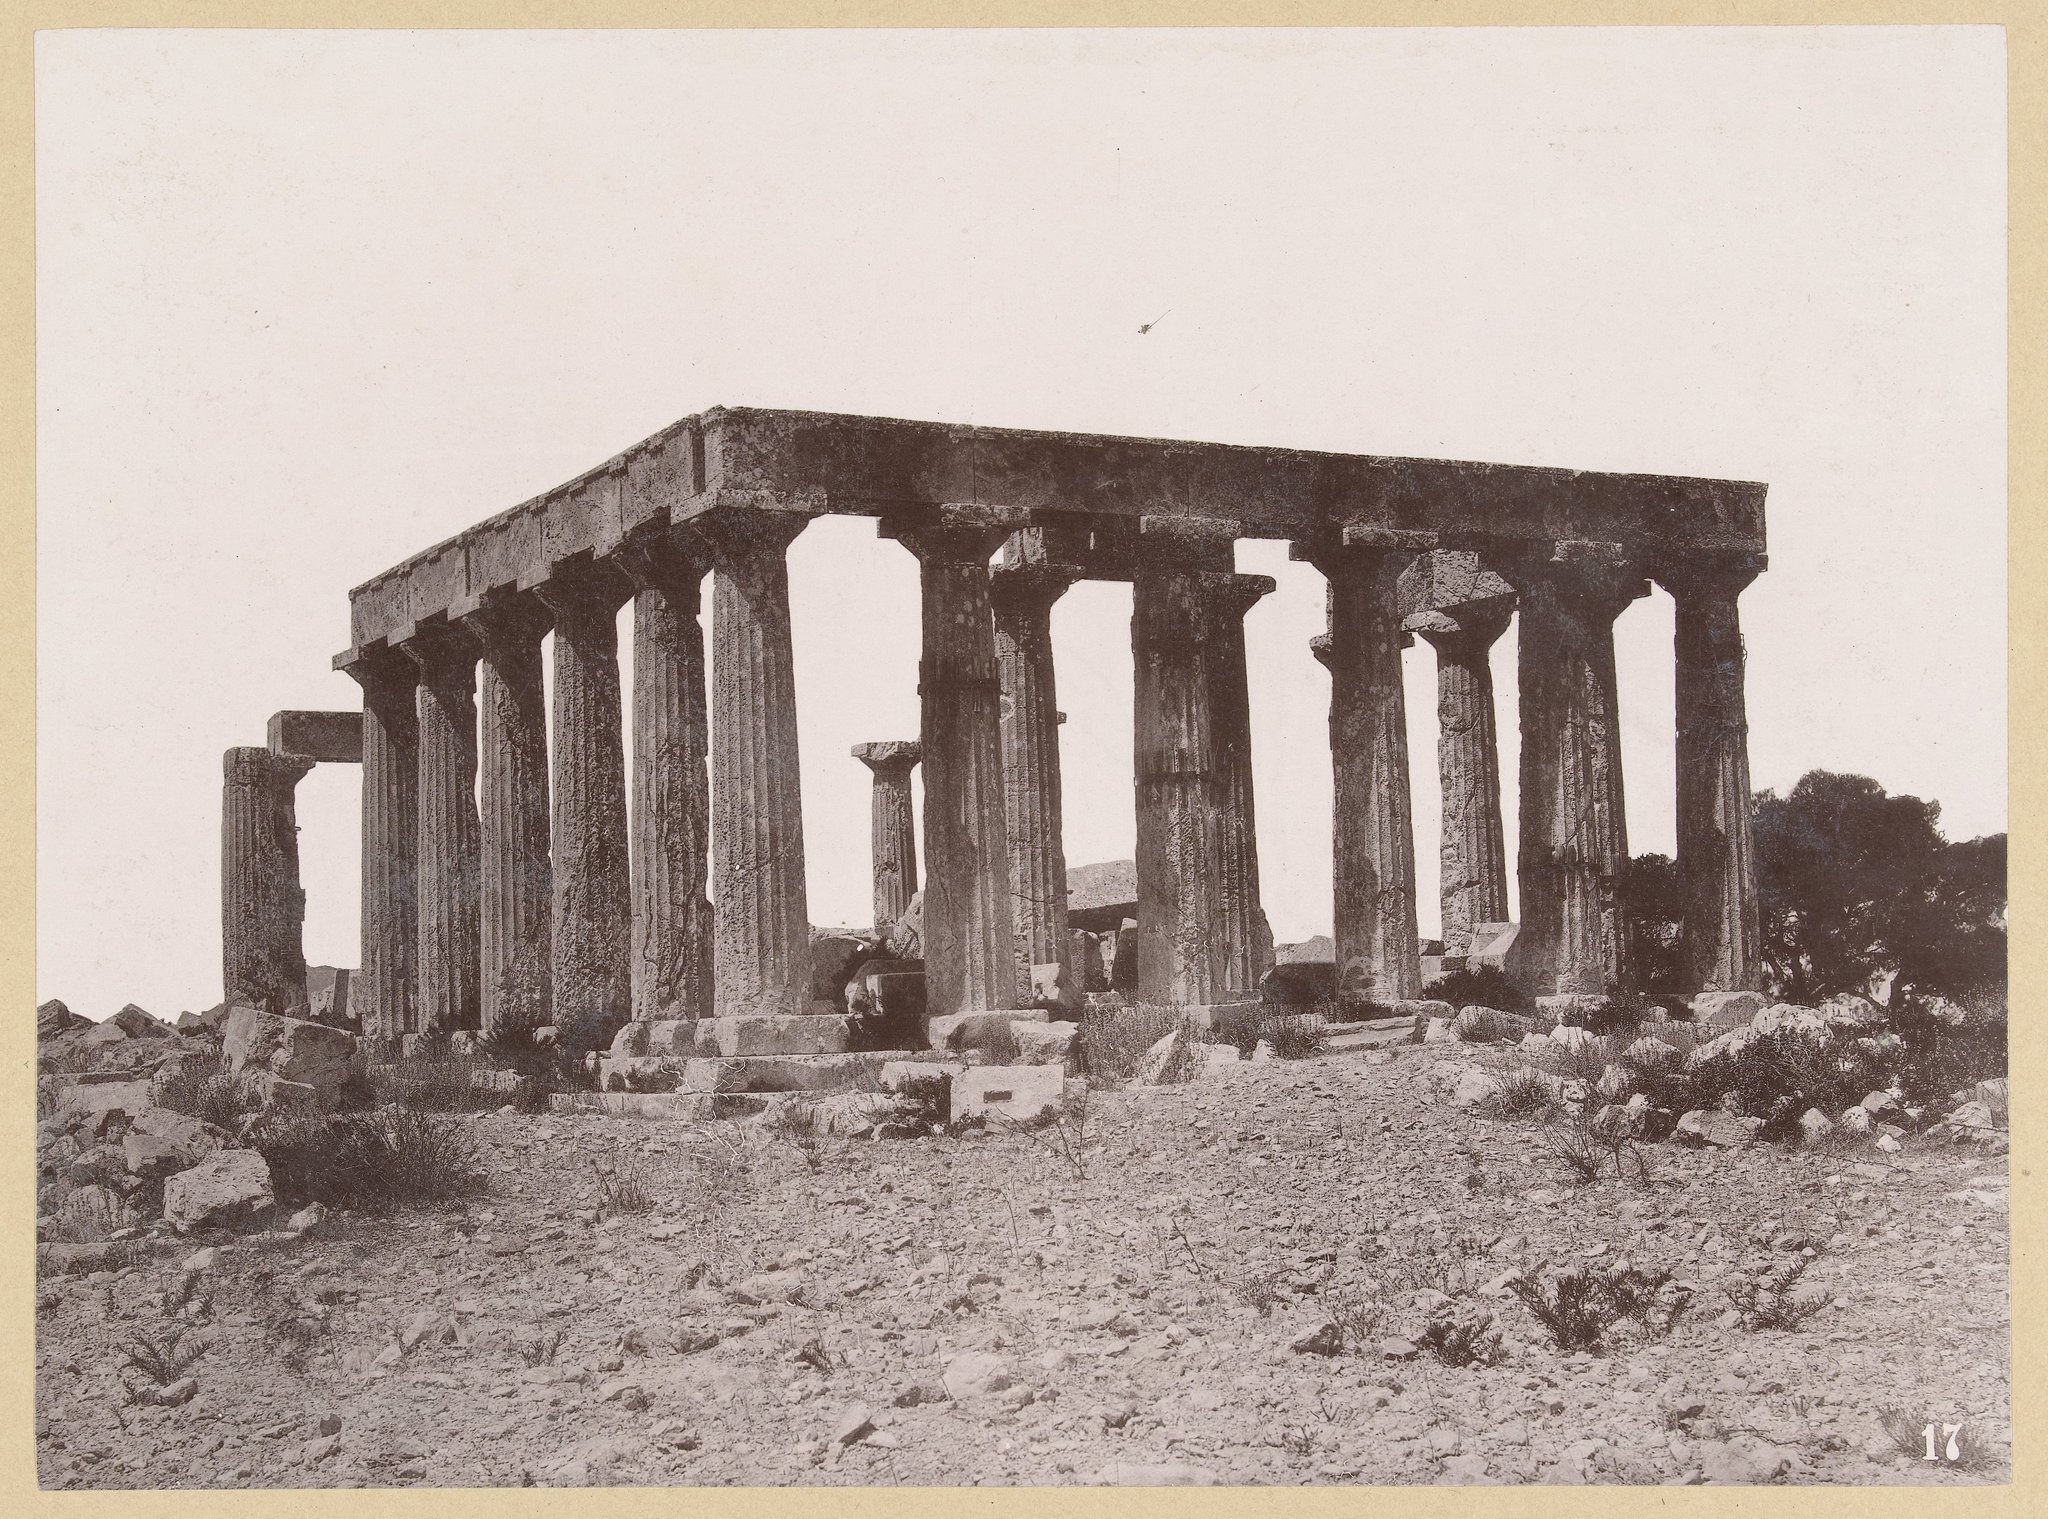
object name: photomechanical print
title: G 58. Tempel van Athena op Aegina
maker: Anonymous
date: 1890-1895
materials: cardboard, paper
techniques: photograph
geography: egina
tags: ruin of a building ~ architecture, temple, shrine ~ greek religion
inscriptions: title: ‘G 58. Tempel van Athena op Aegina.’, number: ‘17’, stamp: ‘Gemeentelijke bibliotheek/ Rotterdam’, check stamp: ‘Bristol/ L.M.’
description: Onderdeel van een groep door fotograaf Richard Polak op reis verzamelde foto’s. Deze fotomechanische afdruk is samen met andere op zijn reizen verzamelde foto's tentoongesteld bij de Rotterdamsche Kunstkring (1895), Arti en Amicitiae te Amsterdam (1897-1898?) en Societeit 't Collegie te Kampen (datum vooralsnog onbekend).